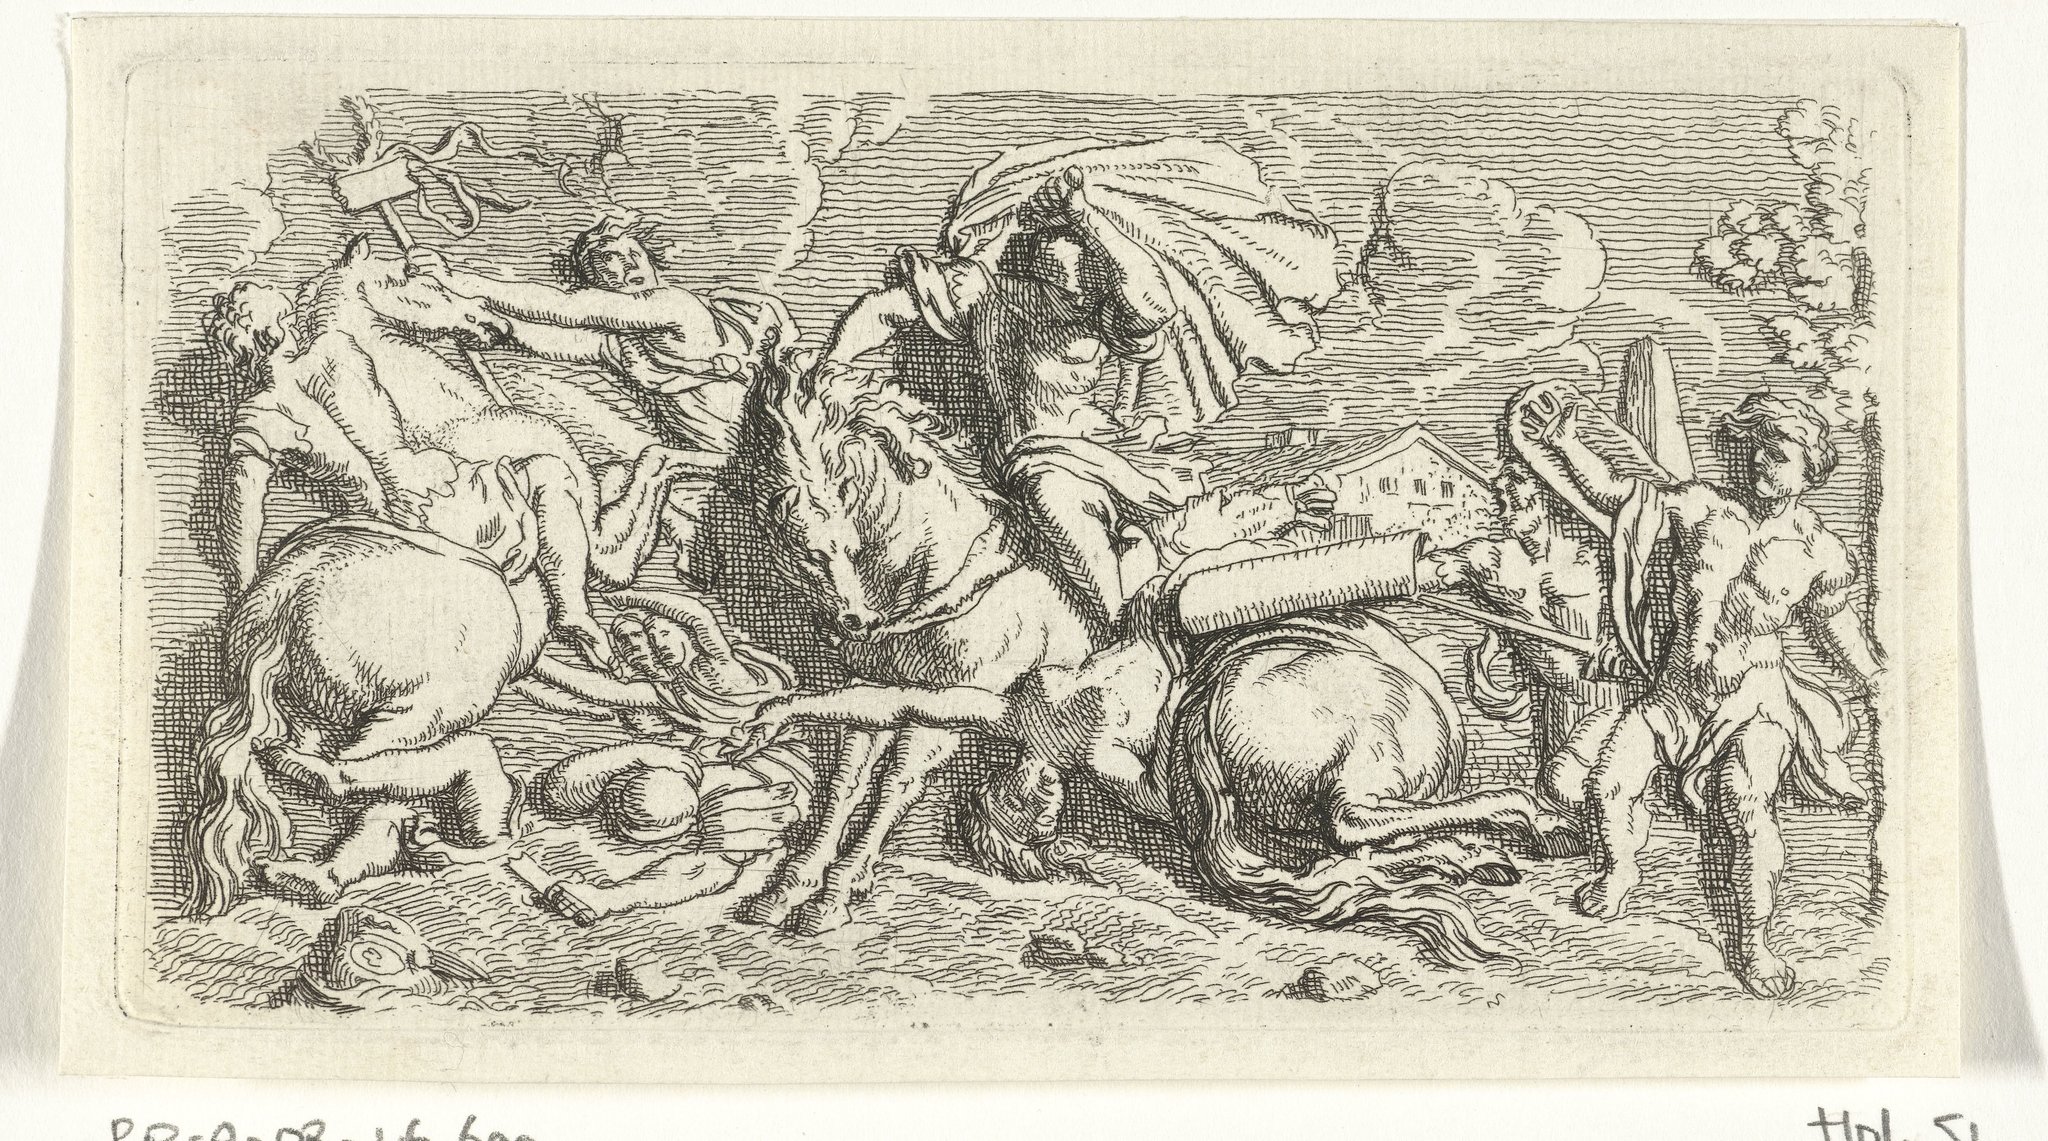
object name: print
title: Amazonenslag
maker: gerard de lairesse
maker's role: draughtsman, painter, print maker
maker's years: 1641-1711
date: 1670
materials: paper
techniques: etching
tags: theseus' fight with the amazons when they attack athens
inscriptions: collector's mark: Lugt 2165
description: Theseus bevecht de Amazonen die Athene aanvallen. Antieke reliëfscène in prent gebracht.